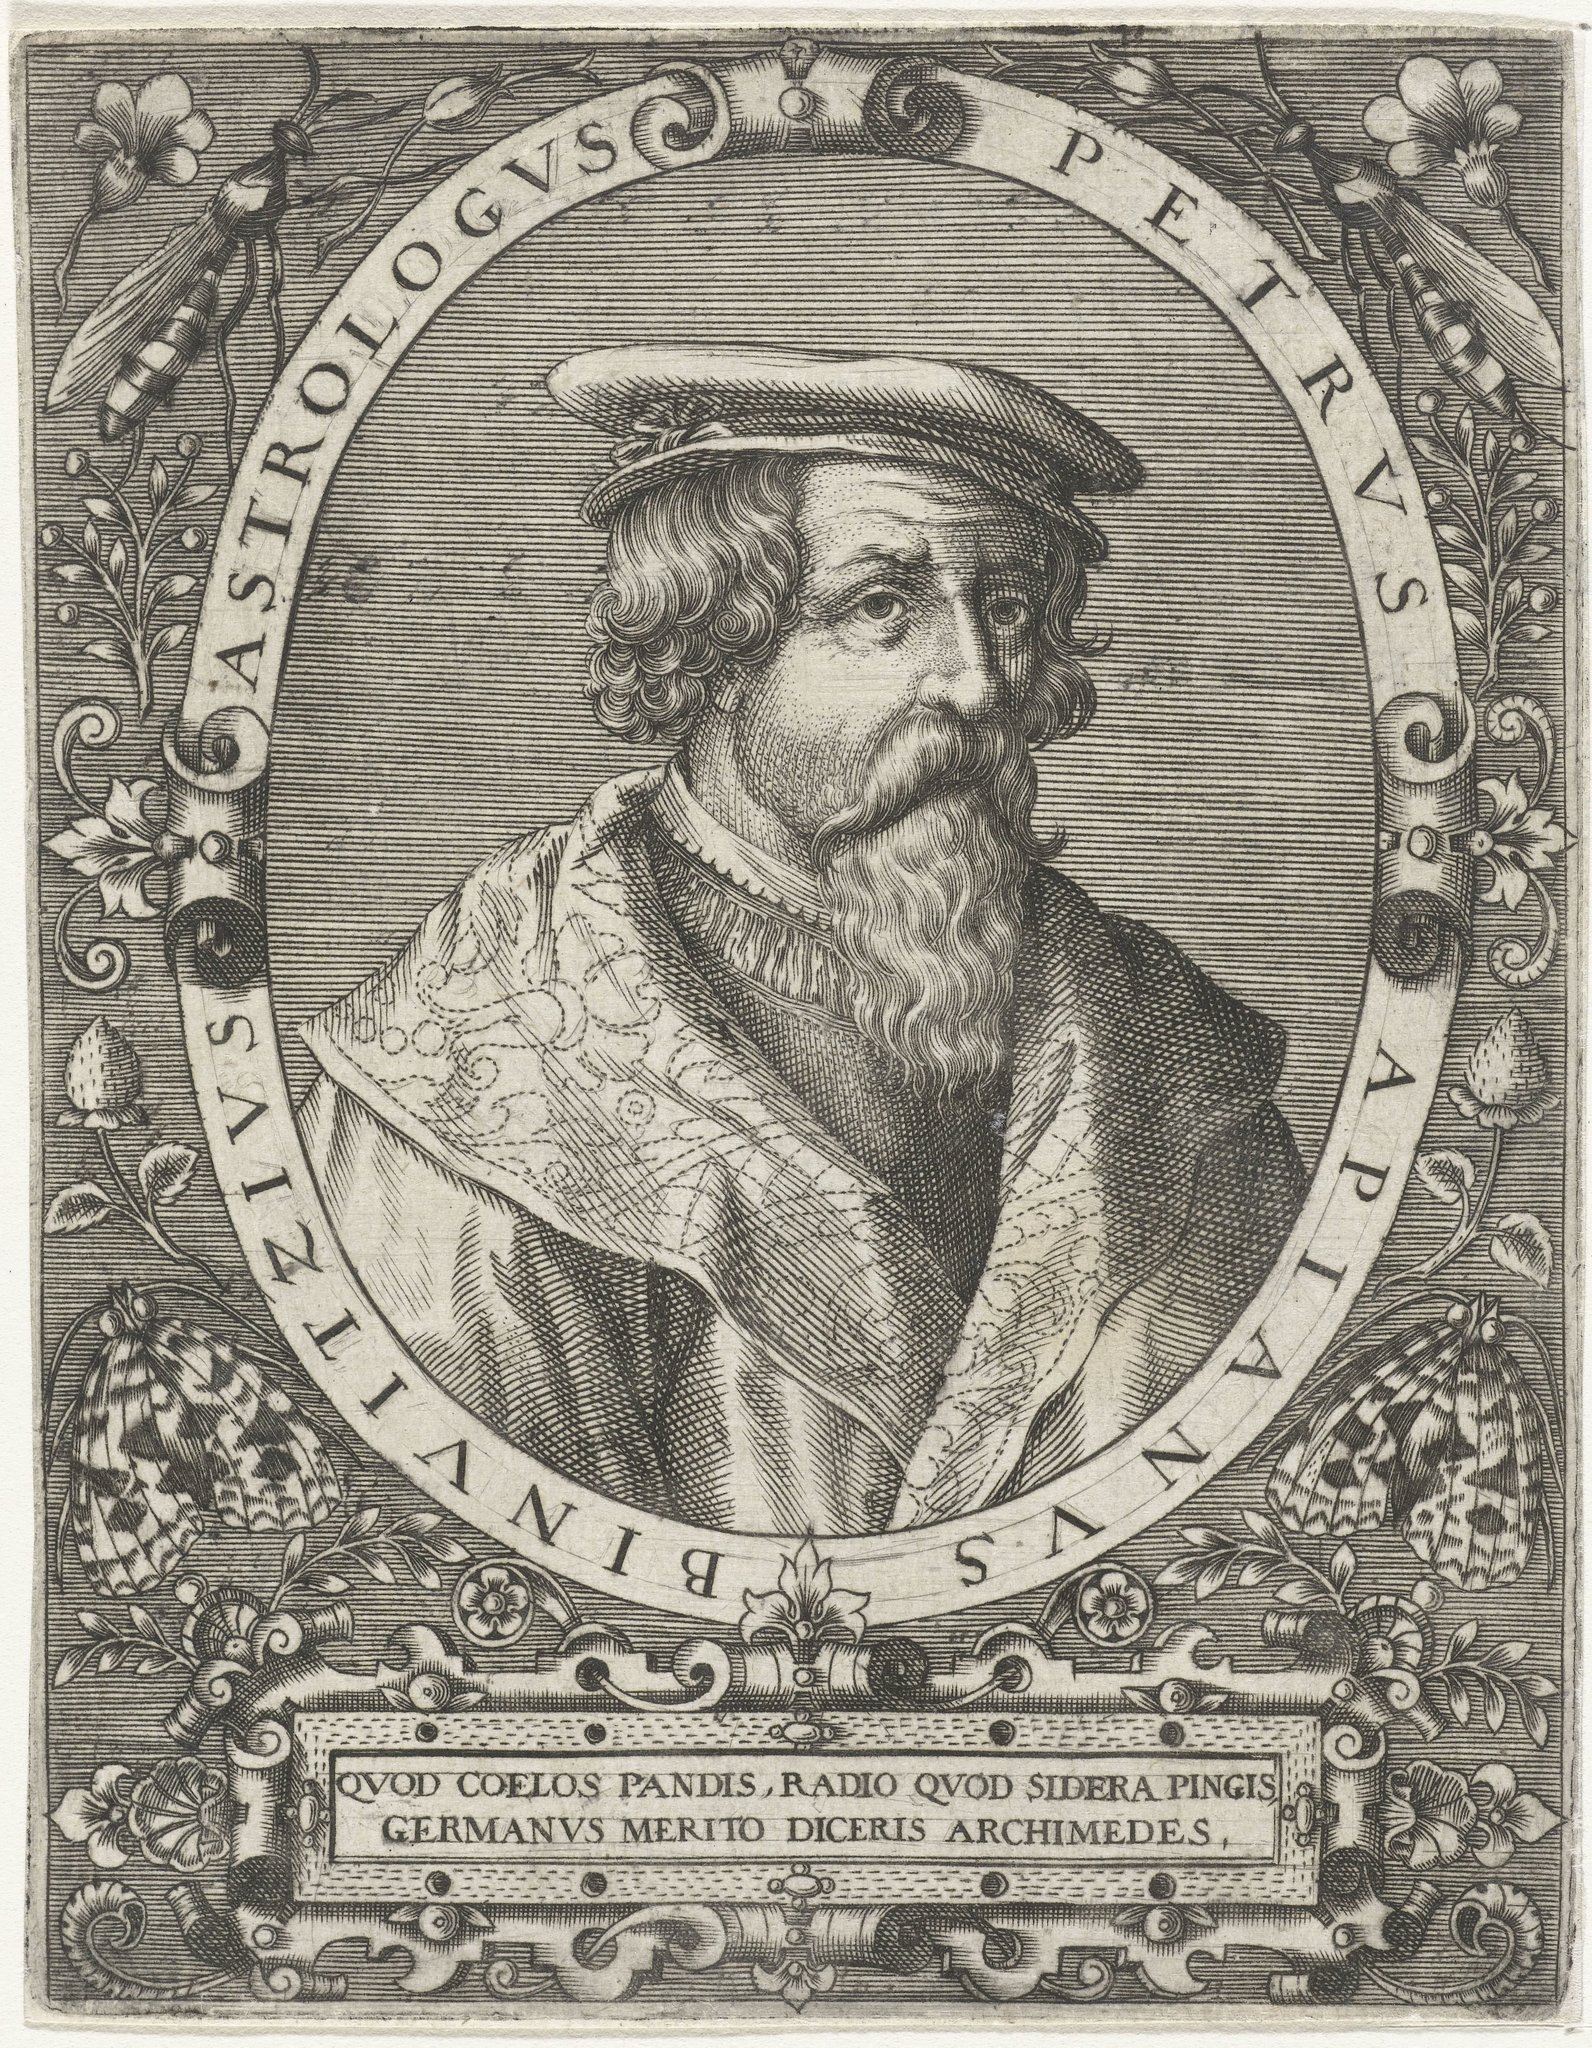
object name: book illustration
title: Petrus Apianus Binuitzius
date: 1597-1599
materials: paper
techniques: engraving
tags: leipzig, ingolstadt, cartograaf, wiskundige, astronoom, petrus apianus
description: Portret van de wiskundige en cartograaf Petrus Apianus, in ovaal met randschrift. In een sierlijst met bloemen en insecten met een cartouche met een Latijns vers onder het portret.